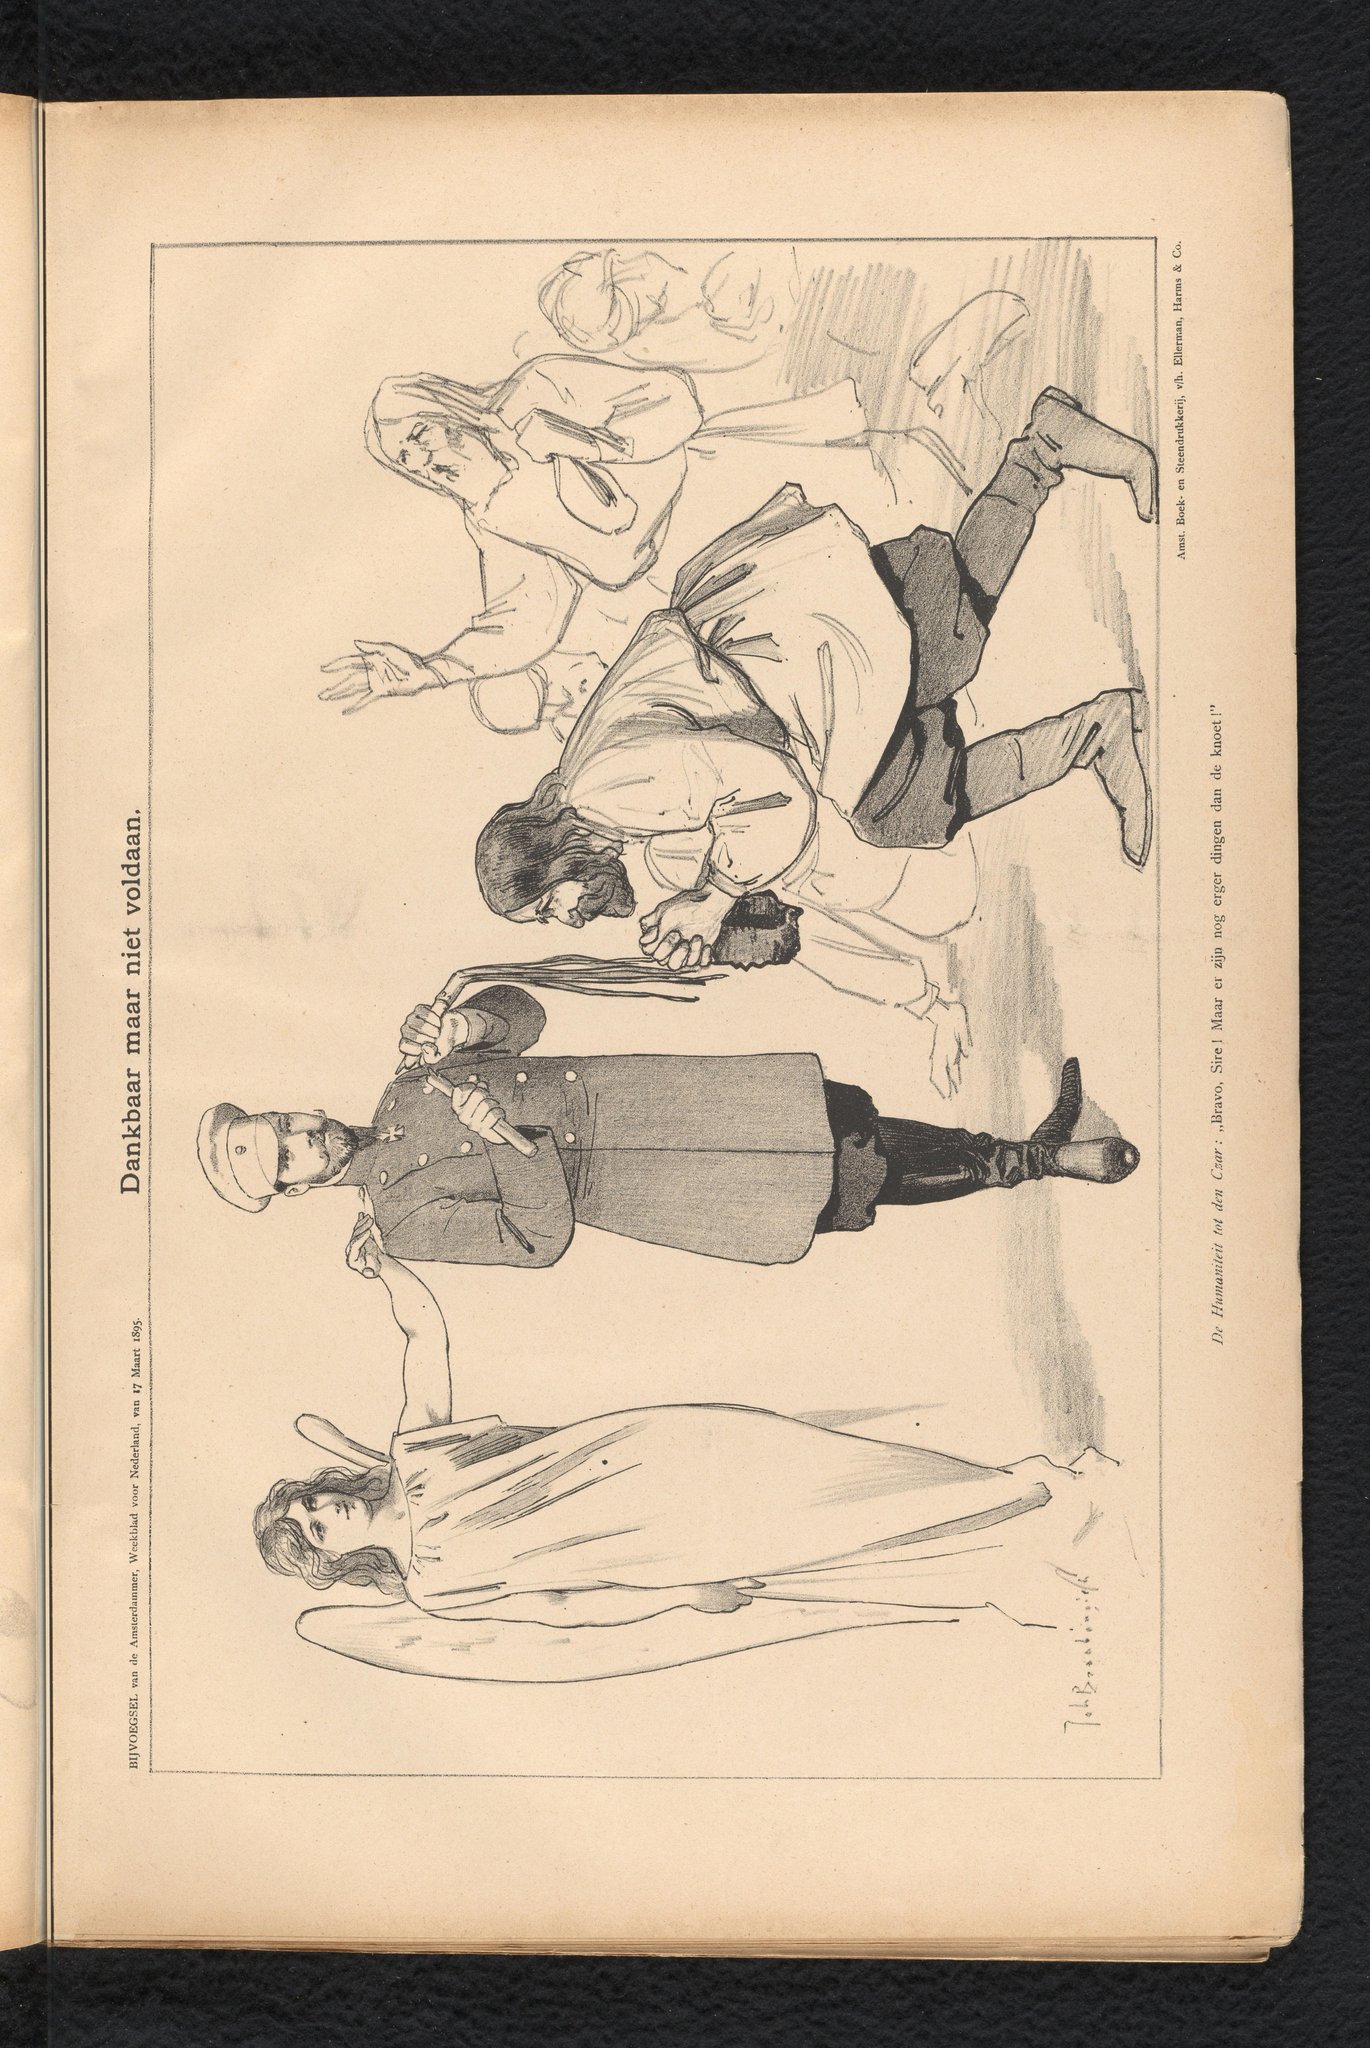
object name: cartoon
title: Dankbaar maar niet voldaan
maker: johan braakensiek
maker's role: draughtsman, print maker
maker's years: 1858-1940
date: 1895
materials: paper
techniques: lithograph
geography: netherlands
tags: political caricatures and satires, russia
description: De engel van Humaniteit dankt de Russische tsaar Nicolaas II die de knoet, waarmee hij de Russische bevolking onderdrukt, doormidden breekt.